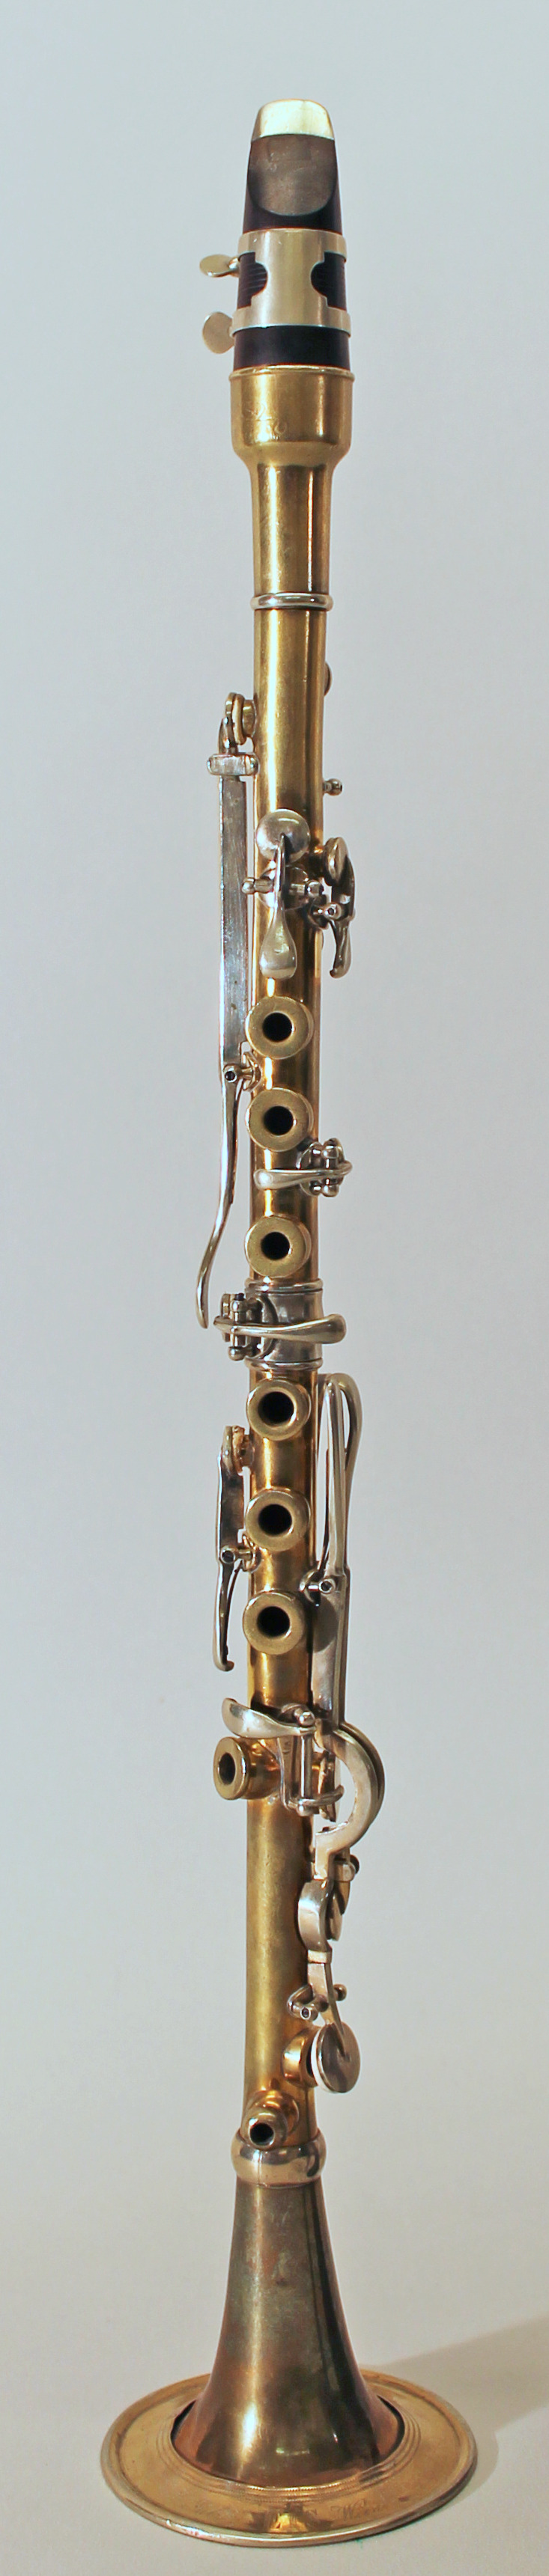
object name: clarinet in e flat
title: Clarinet in E-flat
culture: austrian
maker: c. h. sulz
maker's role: maker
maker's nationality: austrian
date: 1855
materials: brass, nickel, silver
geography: austria